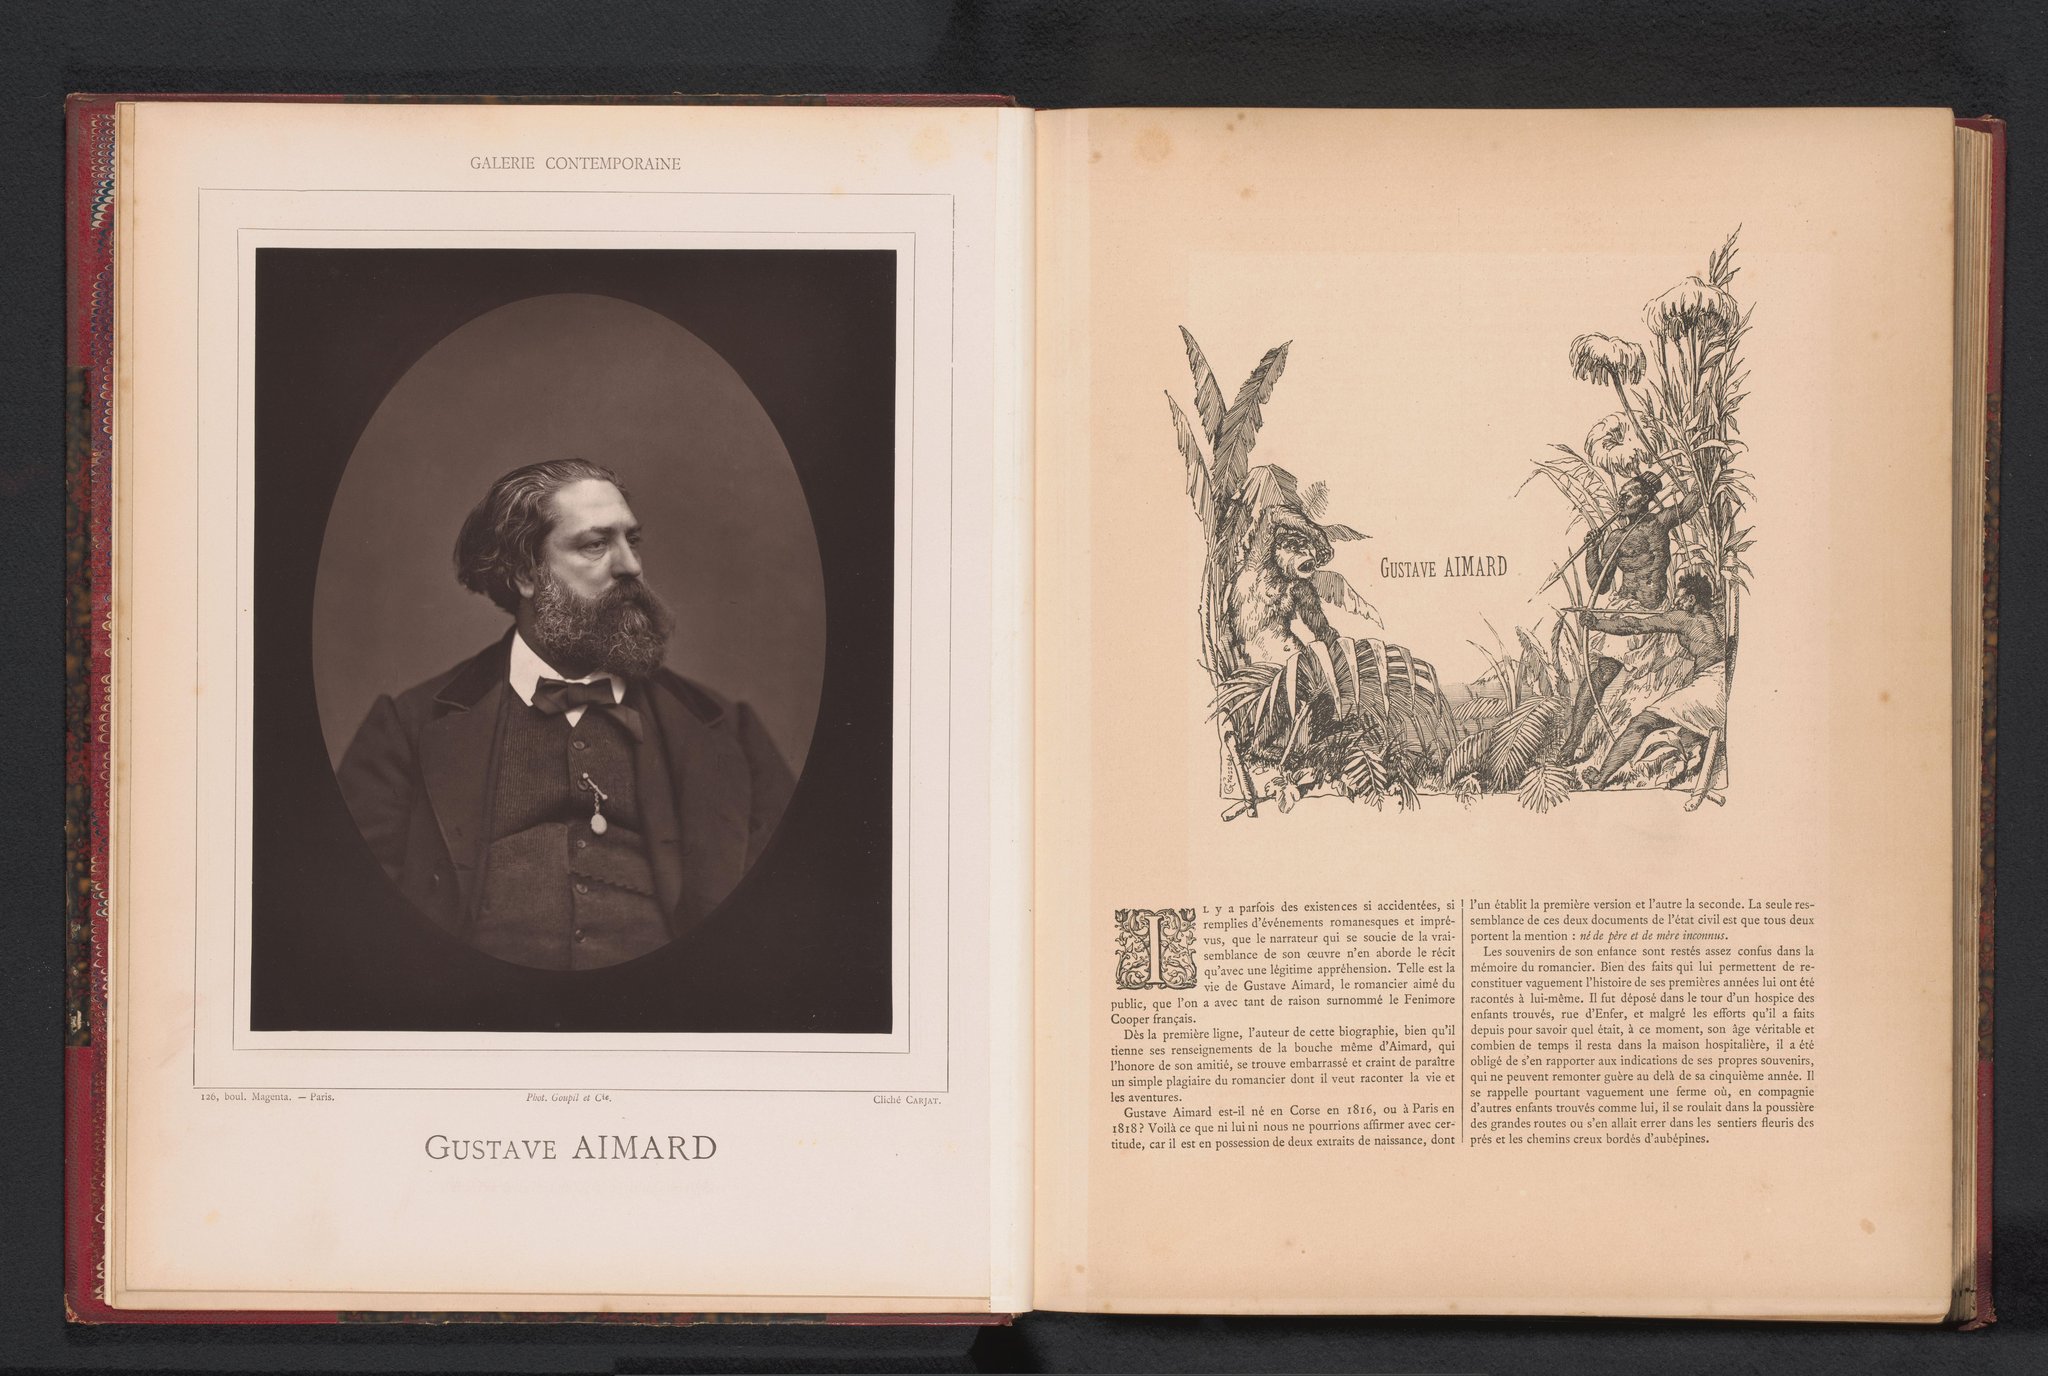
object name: page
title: Gustave Aimard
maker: étienne carjat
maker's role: draughtsman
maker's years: 1828-1906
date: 1876-1879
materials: paper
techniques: woodburytype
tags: paris, adult man, historical persons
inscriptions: inscription: ‘Galerie Contemporaine/ 126, boul. Magenta. - Paris.’